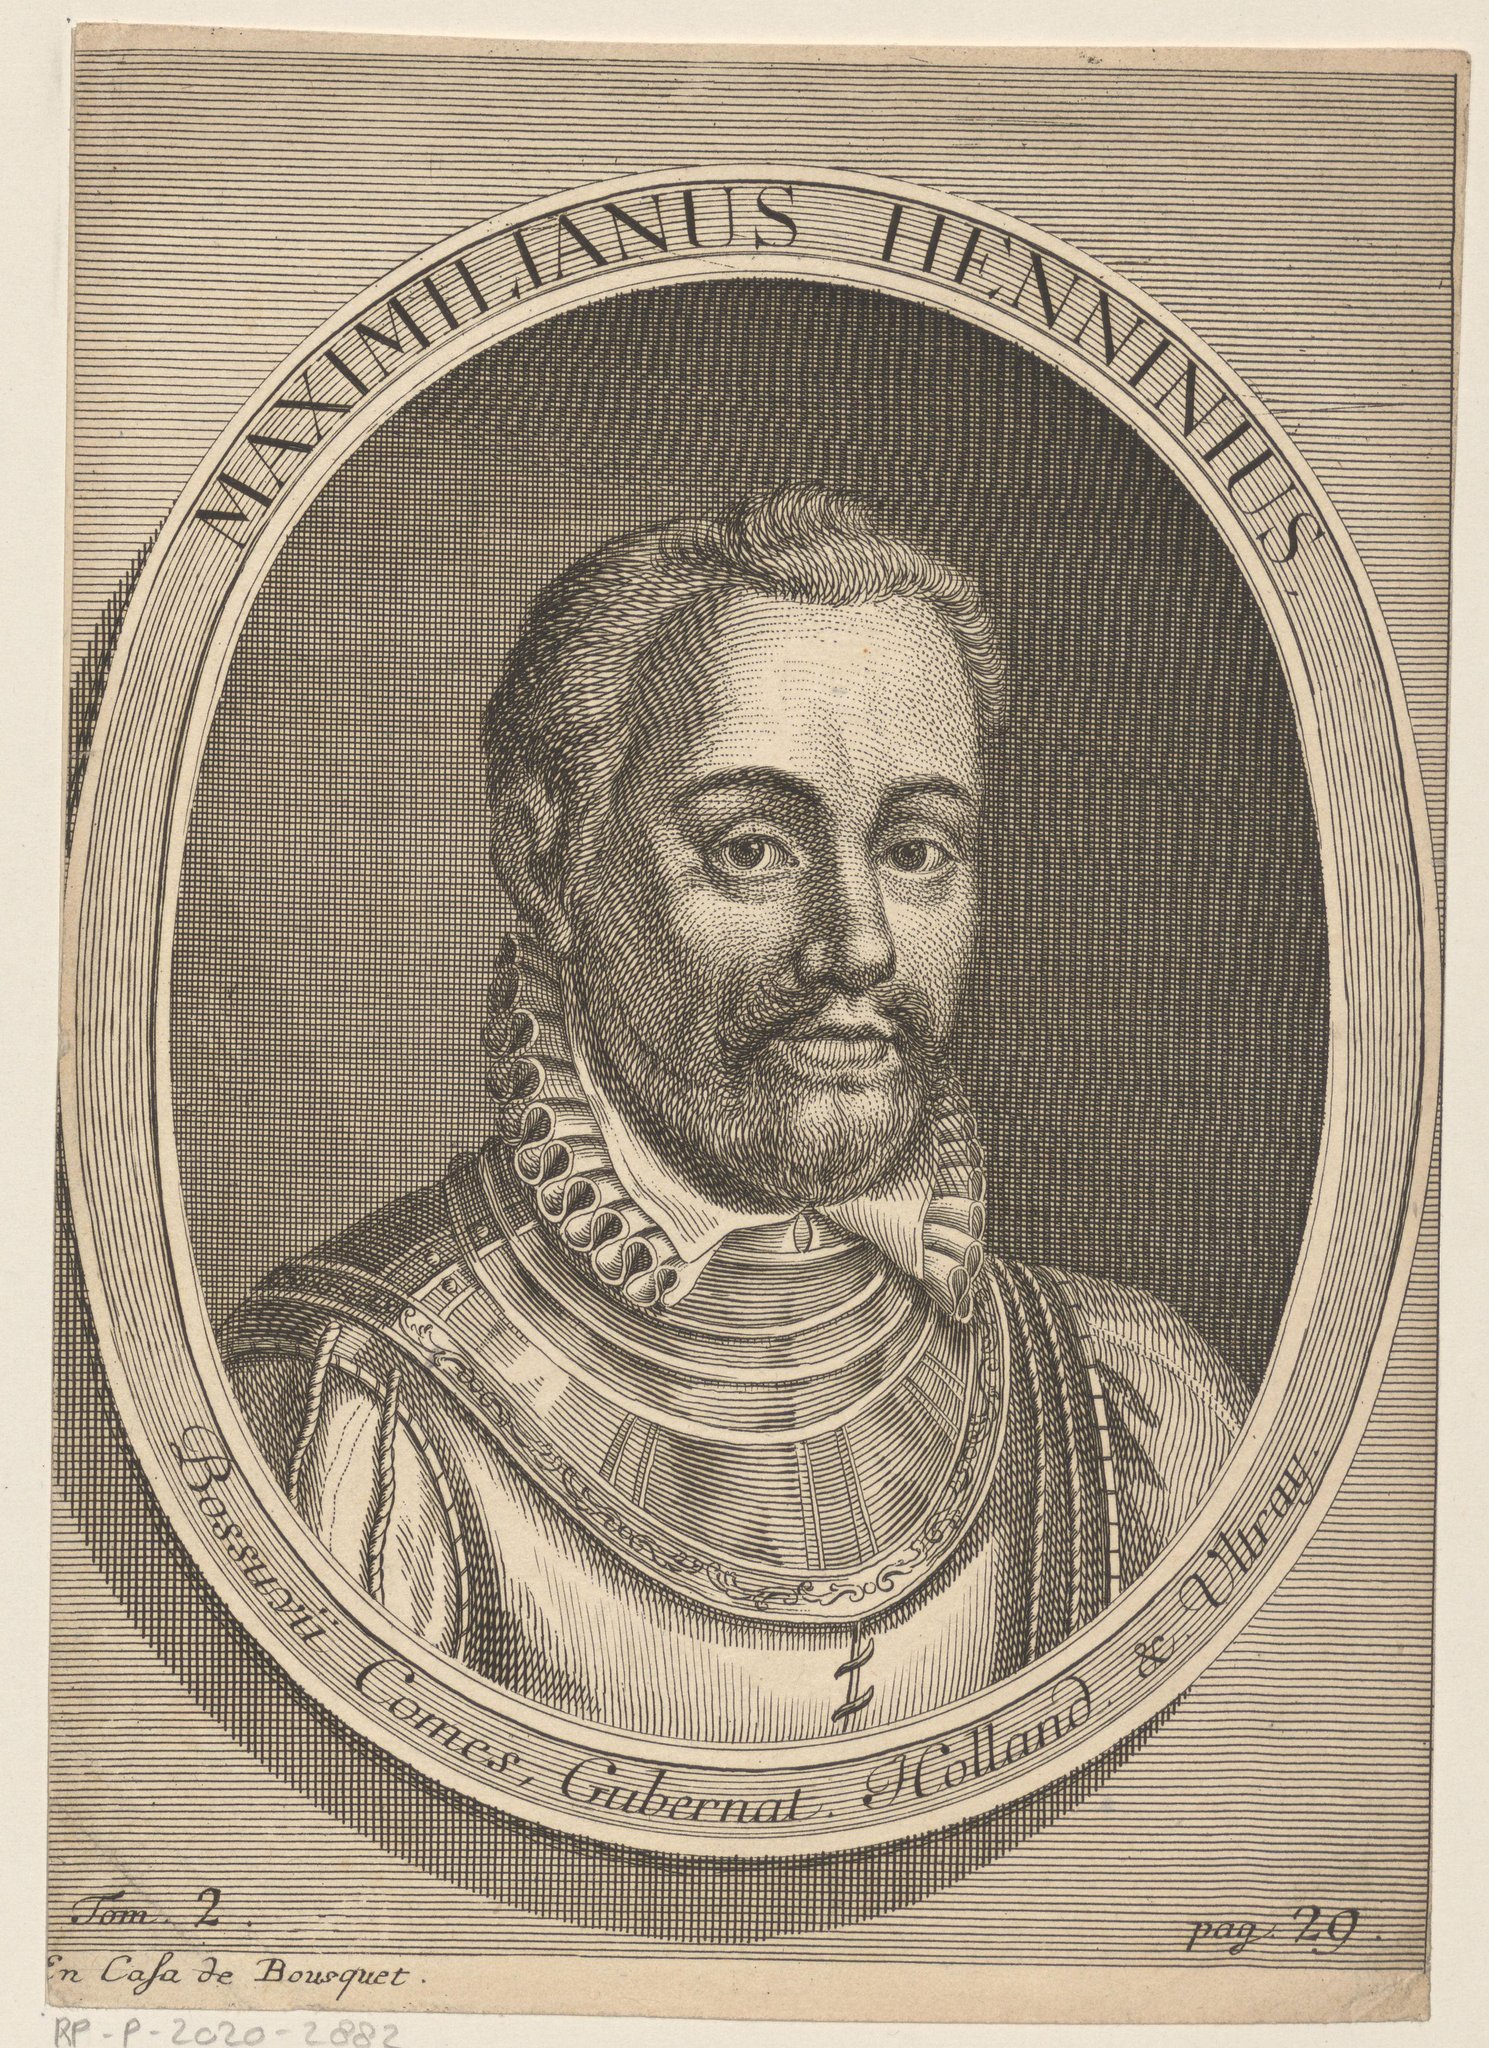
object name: book illustration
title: Portret van Maximiliaan, graaf van Hennin-Lietard en Boussu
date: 1749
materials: paper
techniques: engraving, etching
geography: antwerp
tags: earl, historical persons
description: Prent uit: Strada, Famiano. Guerras de Flandes. Segunda decada (...). Antwerpen: Marc-Michel Bousquet, 1749, dl. 2.